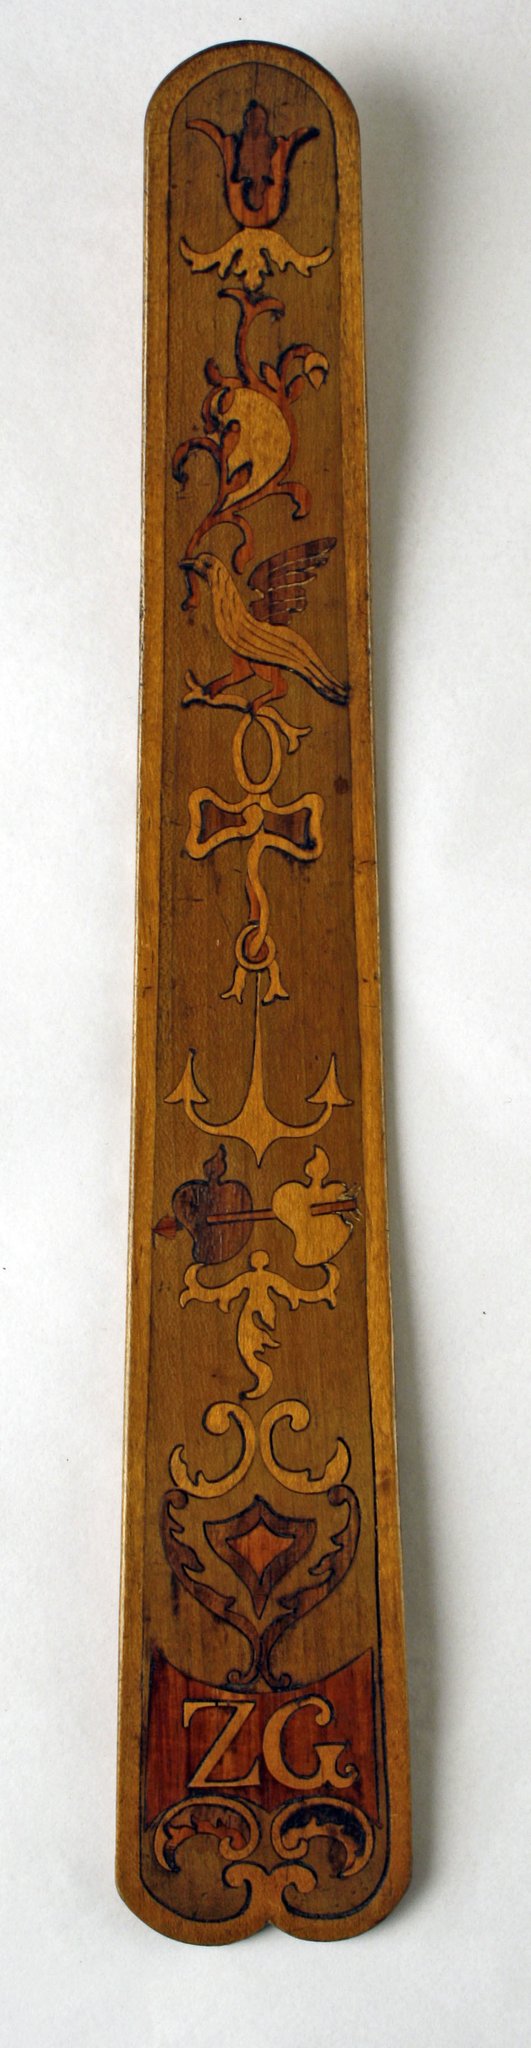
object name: busk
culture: european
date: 1701-1800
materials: wood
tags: birds